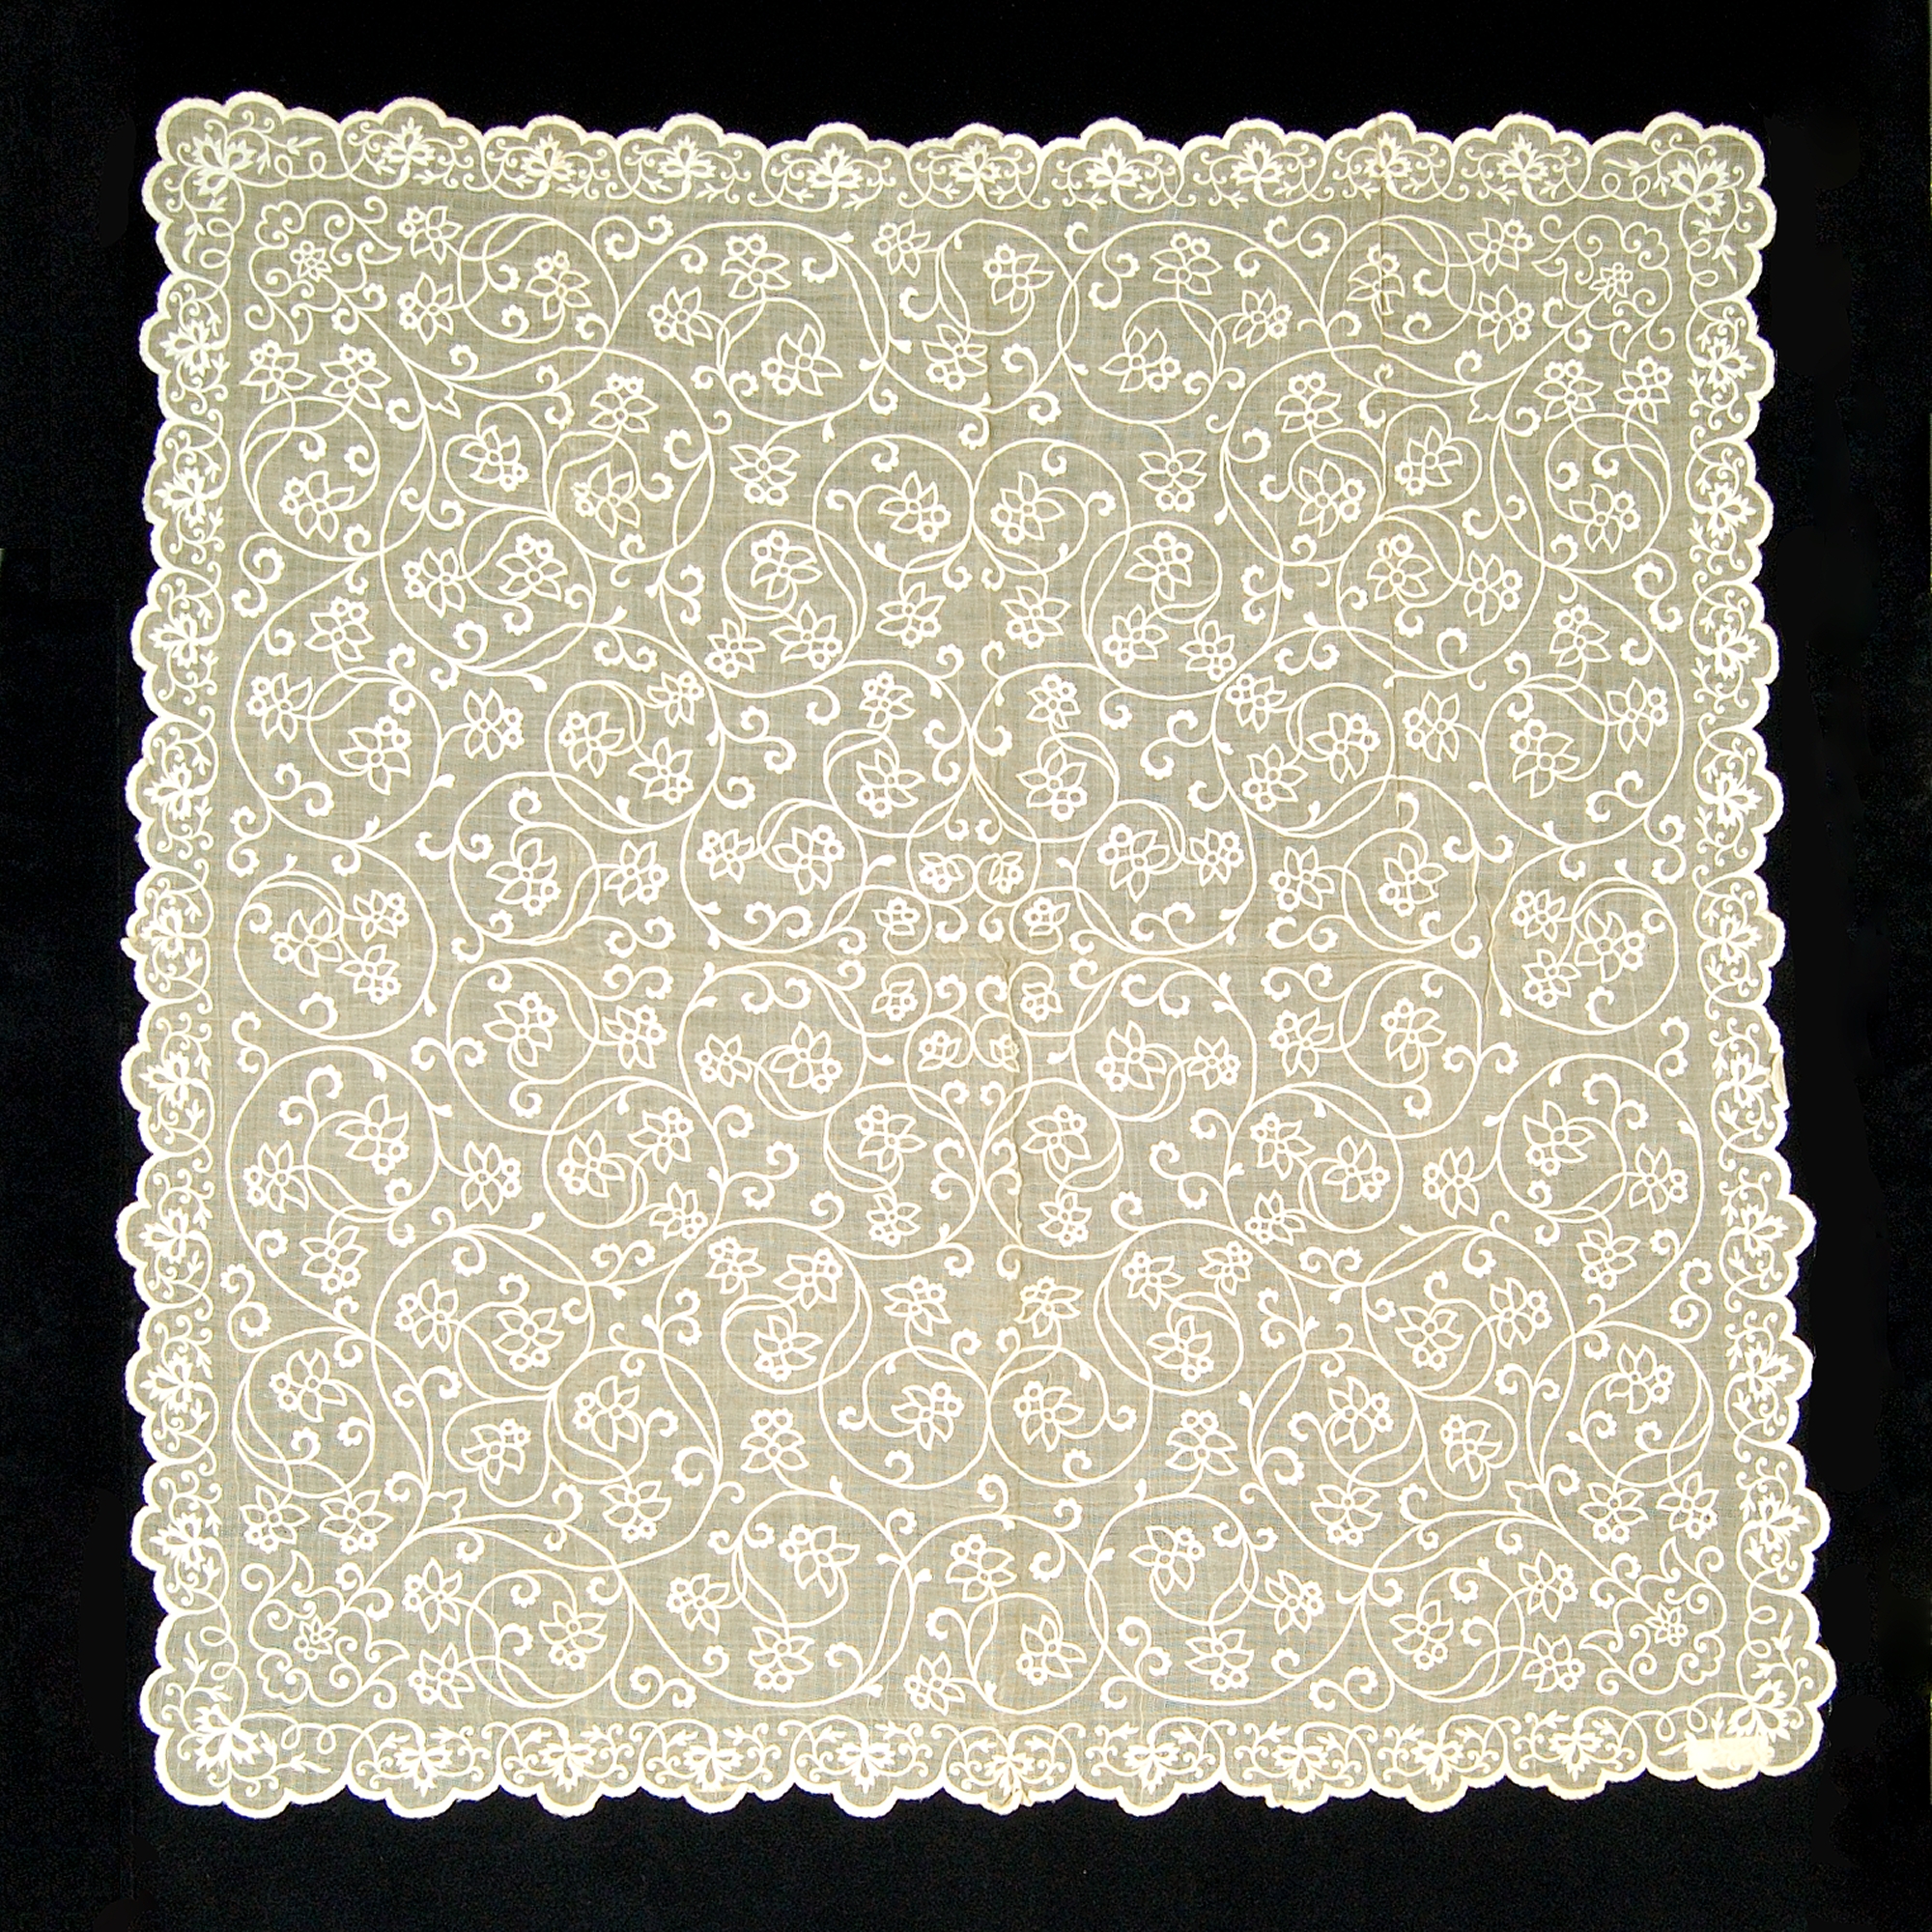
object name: fichu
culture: philippine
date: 1851-1875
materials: cotton, fiber